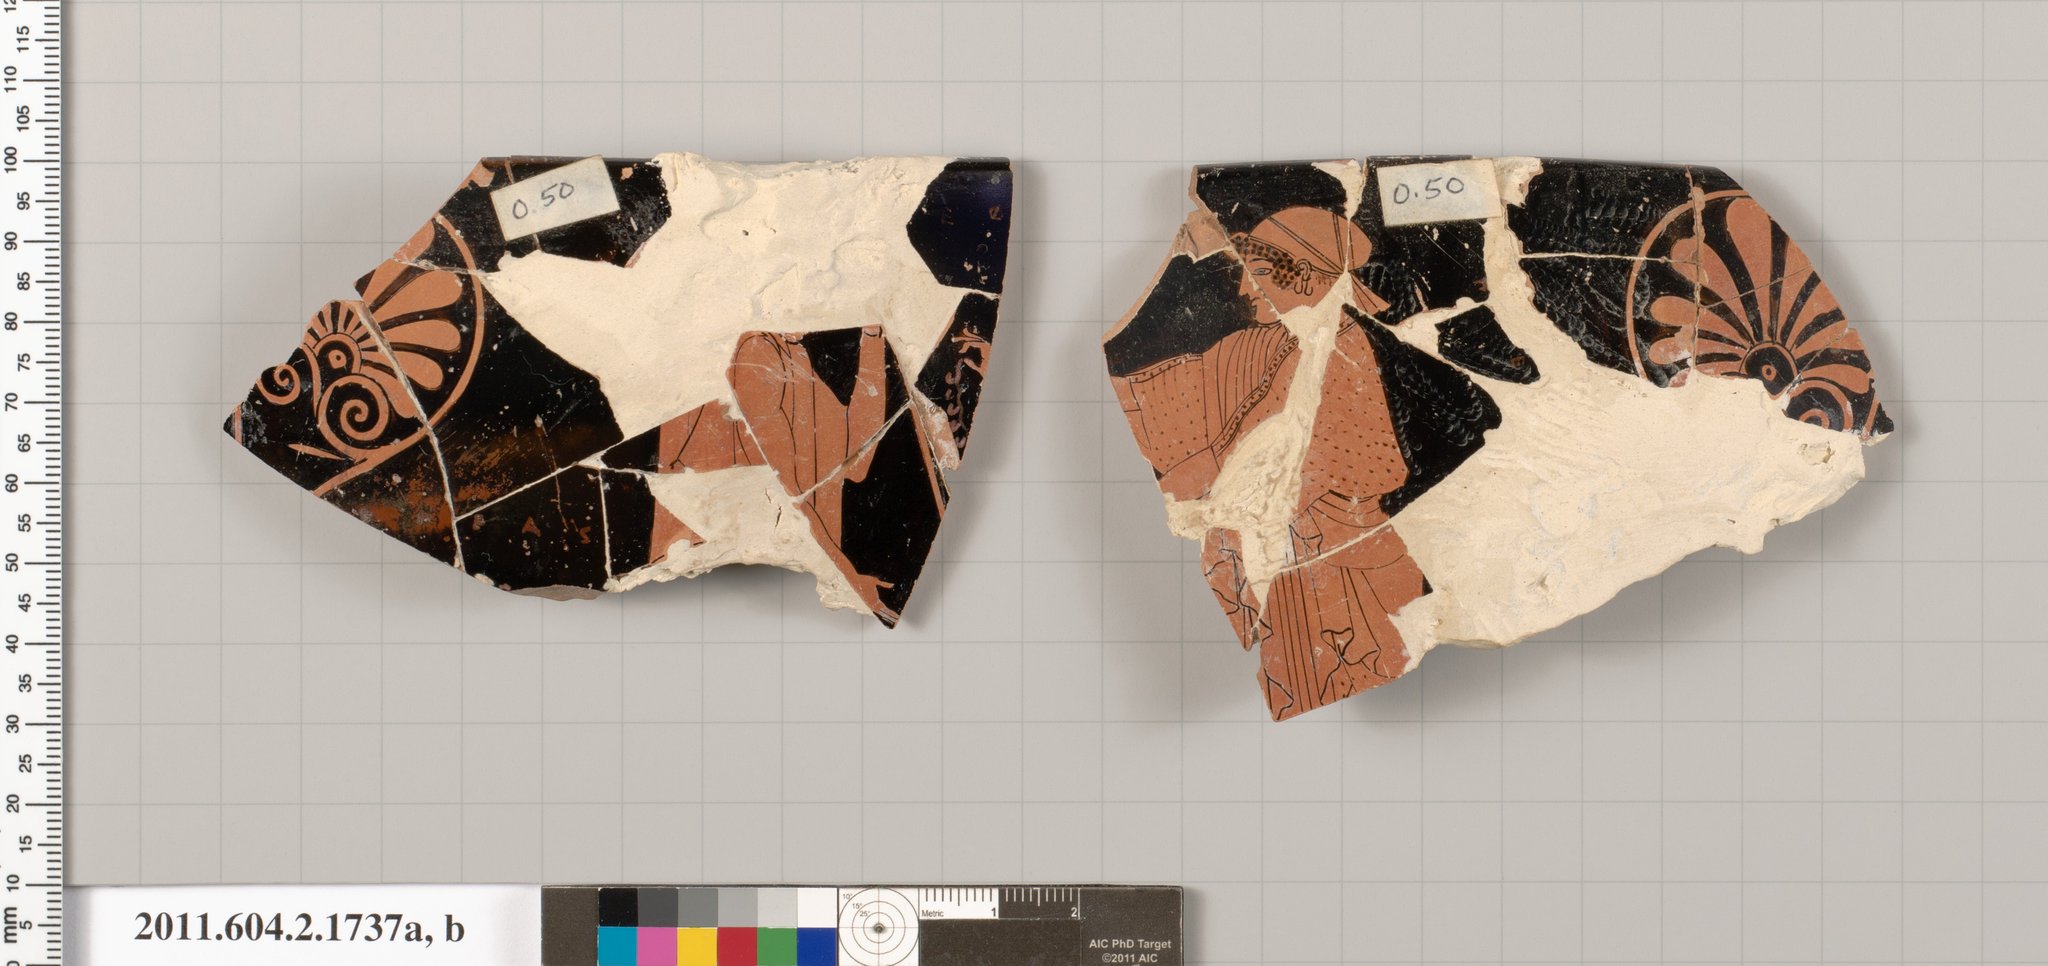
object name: skyphos fragment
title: Terracotta fragments of a skyphos (deep drinking cup)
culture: greek, attic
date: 500-480 BCE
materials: terracotta